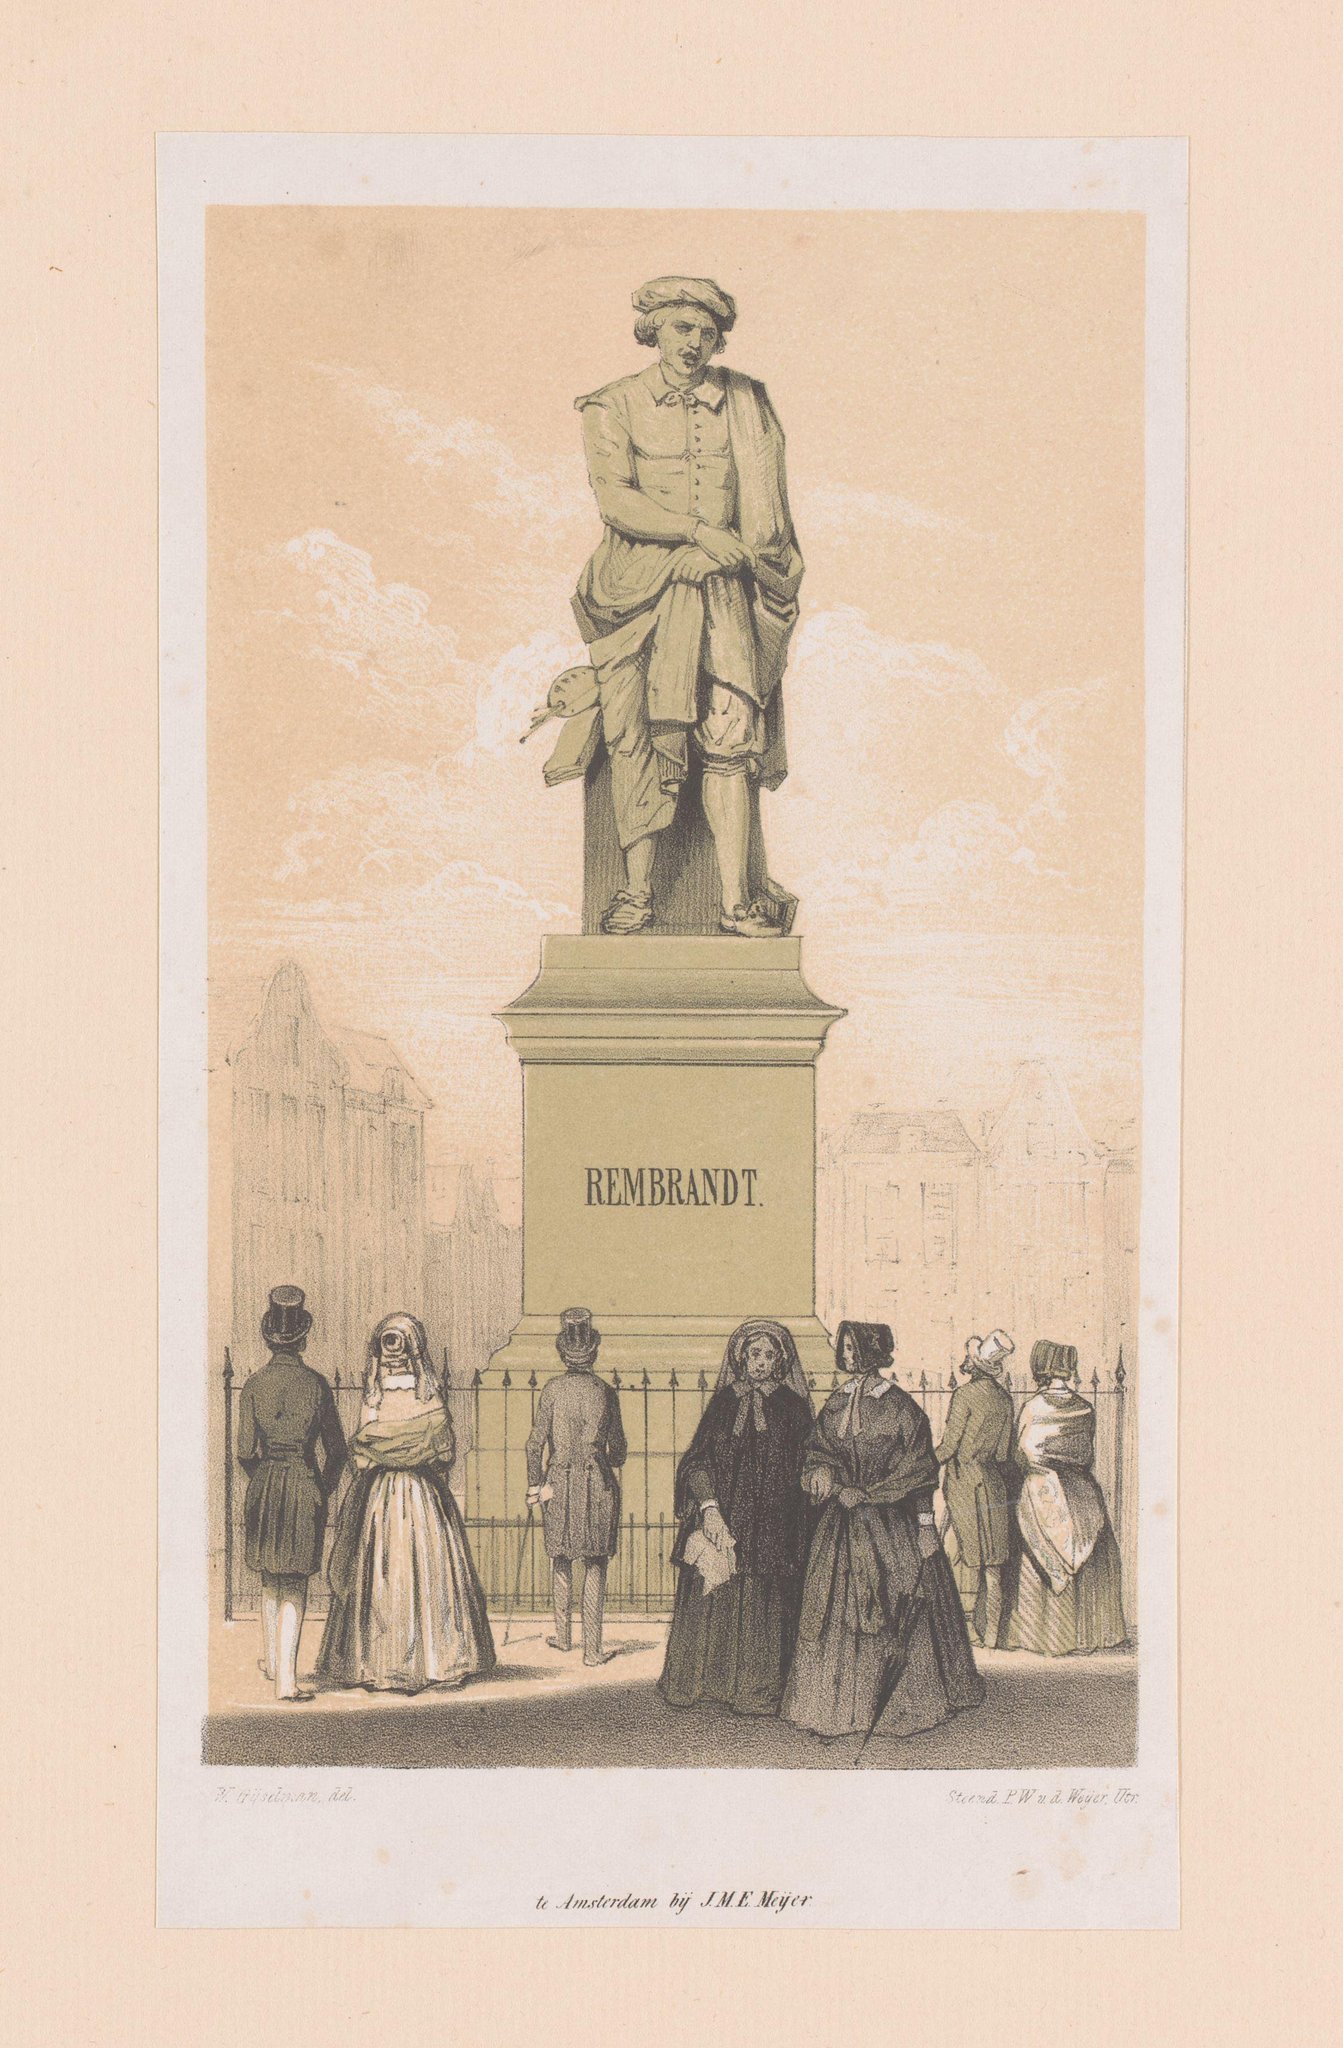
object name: print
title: Standbeeld van Rembrandt in Amsterdam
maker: pieter wilhelmus van de weijer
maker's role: print maker, printer, publisher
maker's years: 1816-1880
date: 1842-1900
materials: paper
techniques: tone lithography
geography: utrecht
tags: amsterdam, painter, print maker, draughtsman, rembrandt van rijn, piece of sculpture, reproduction of a piece of sculpture, monument, statue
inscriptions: collector's mark: Lugt 2228, collector's mark: Lugt 2760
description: Voor het standbeeld staan enkele figuren.